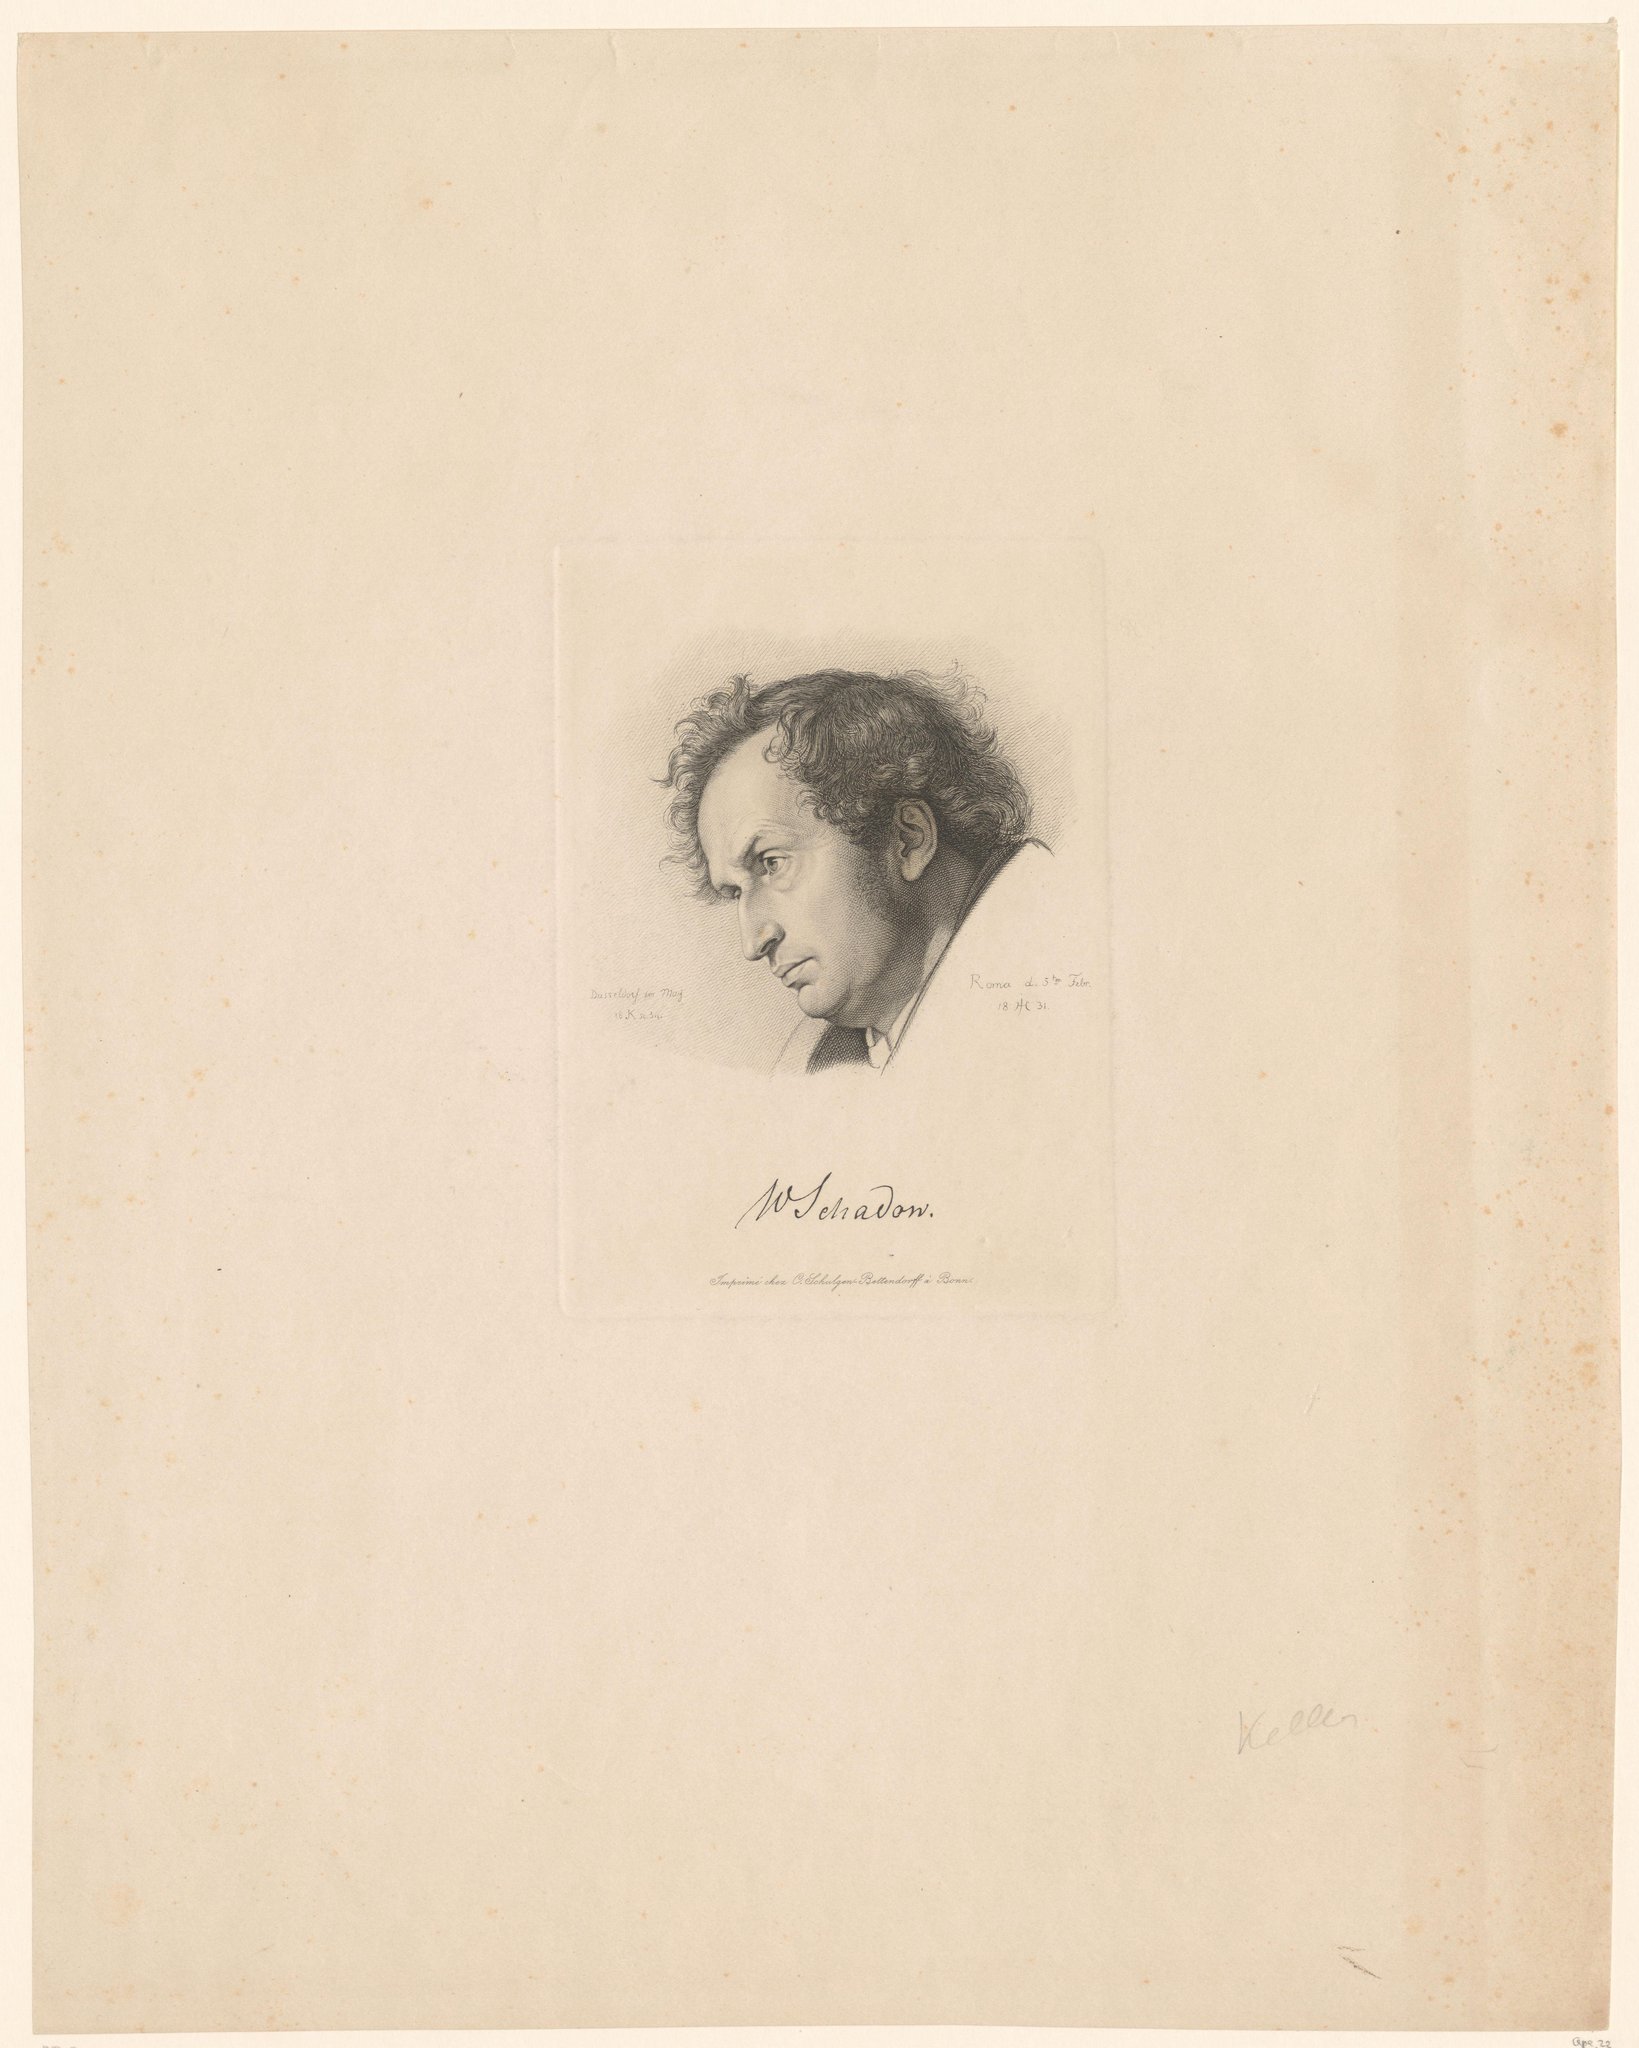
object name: print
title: Portret van Wilhelm Schadow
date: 1831-1873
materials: paper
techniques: engraving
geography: bonn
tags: berlin, print maker, wilhelm schadow, historical persons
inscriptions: collector's mark: Lugt 2228